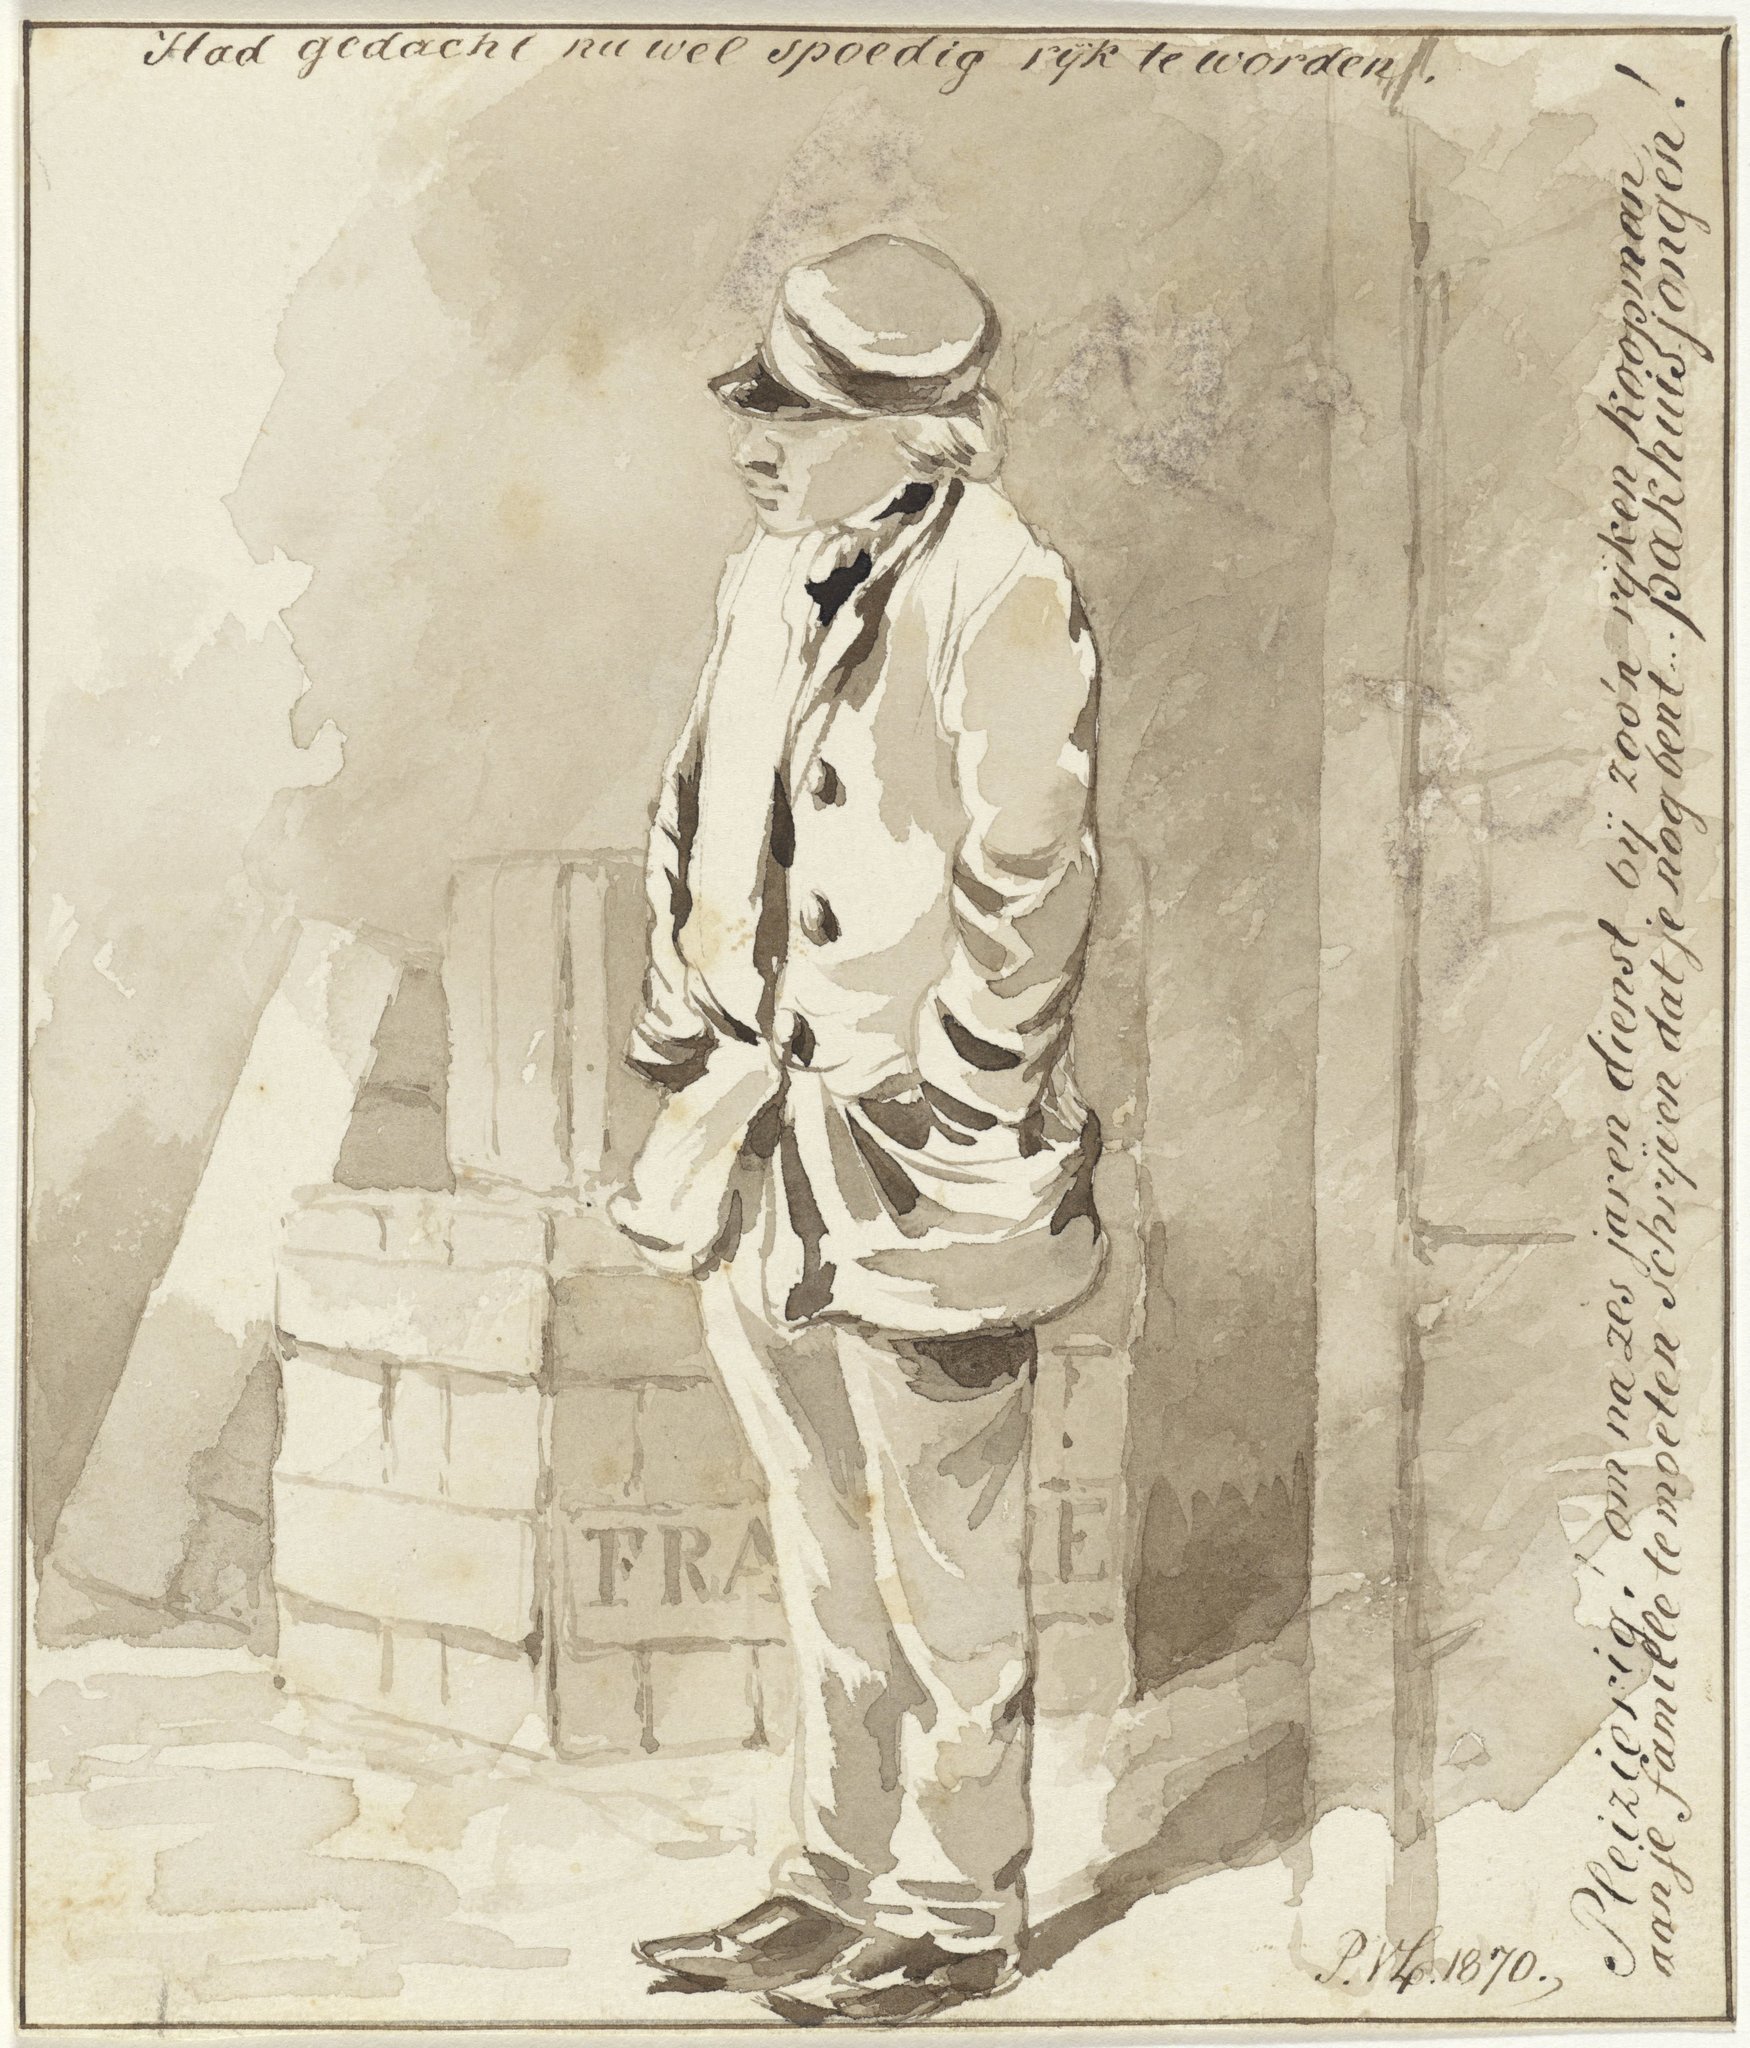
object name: drawing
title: Staande jongeman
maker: pieter van loon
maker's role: draughtsman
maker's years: 1801-1873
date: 1870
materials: paper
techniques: brush